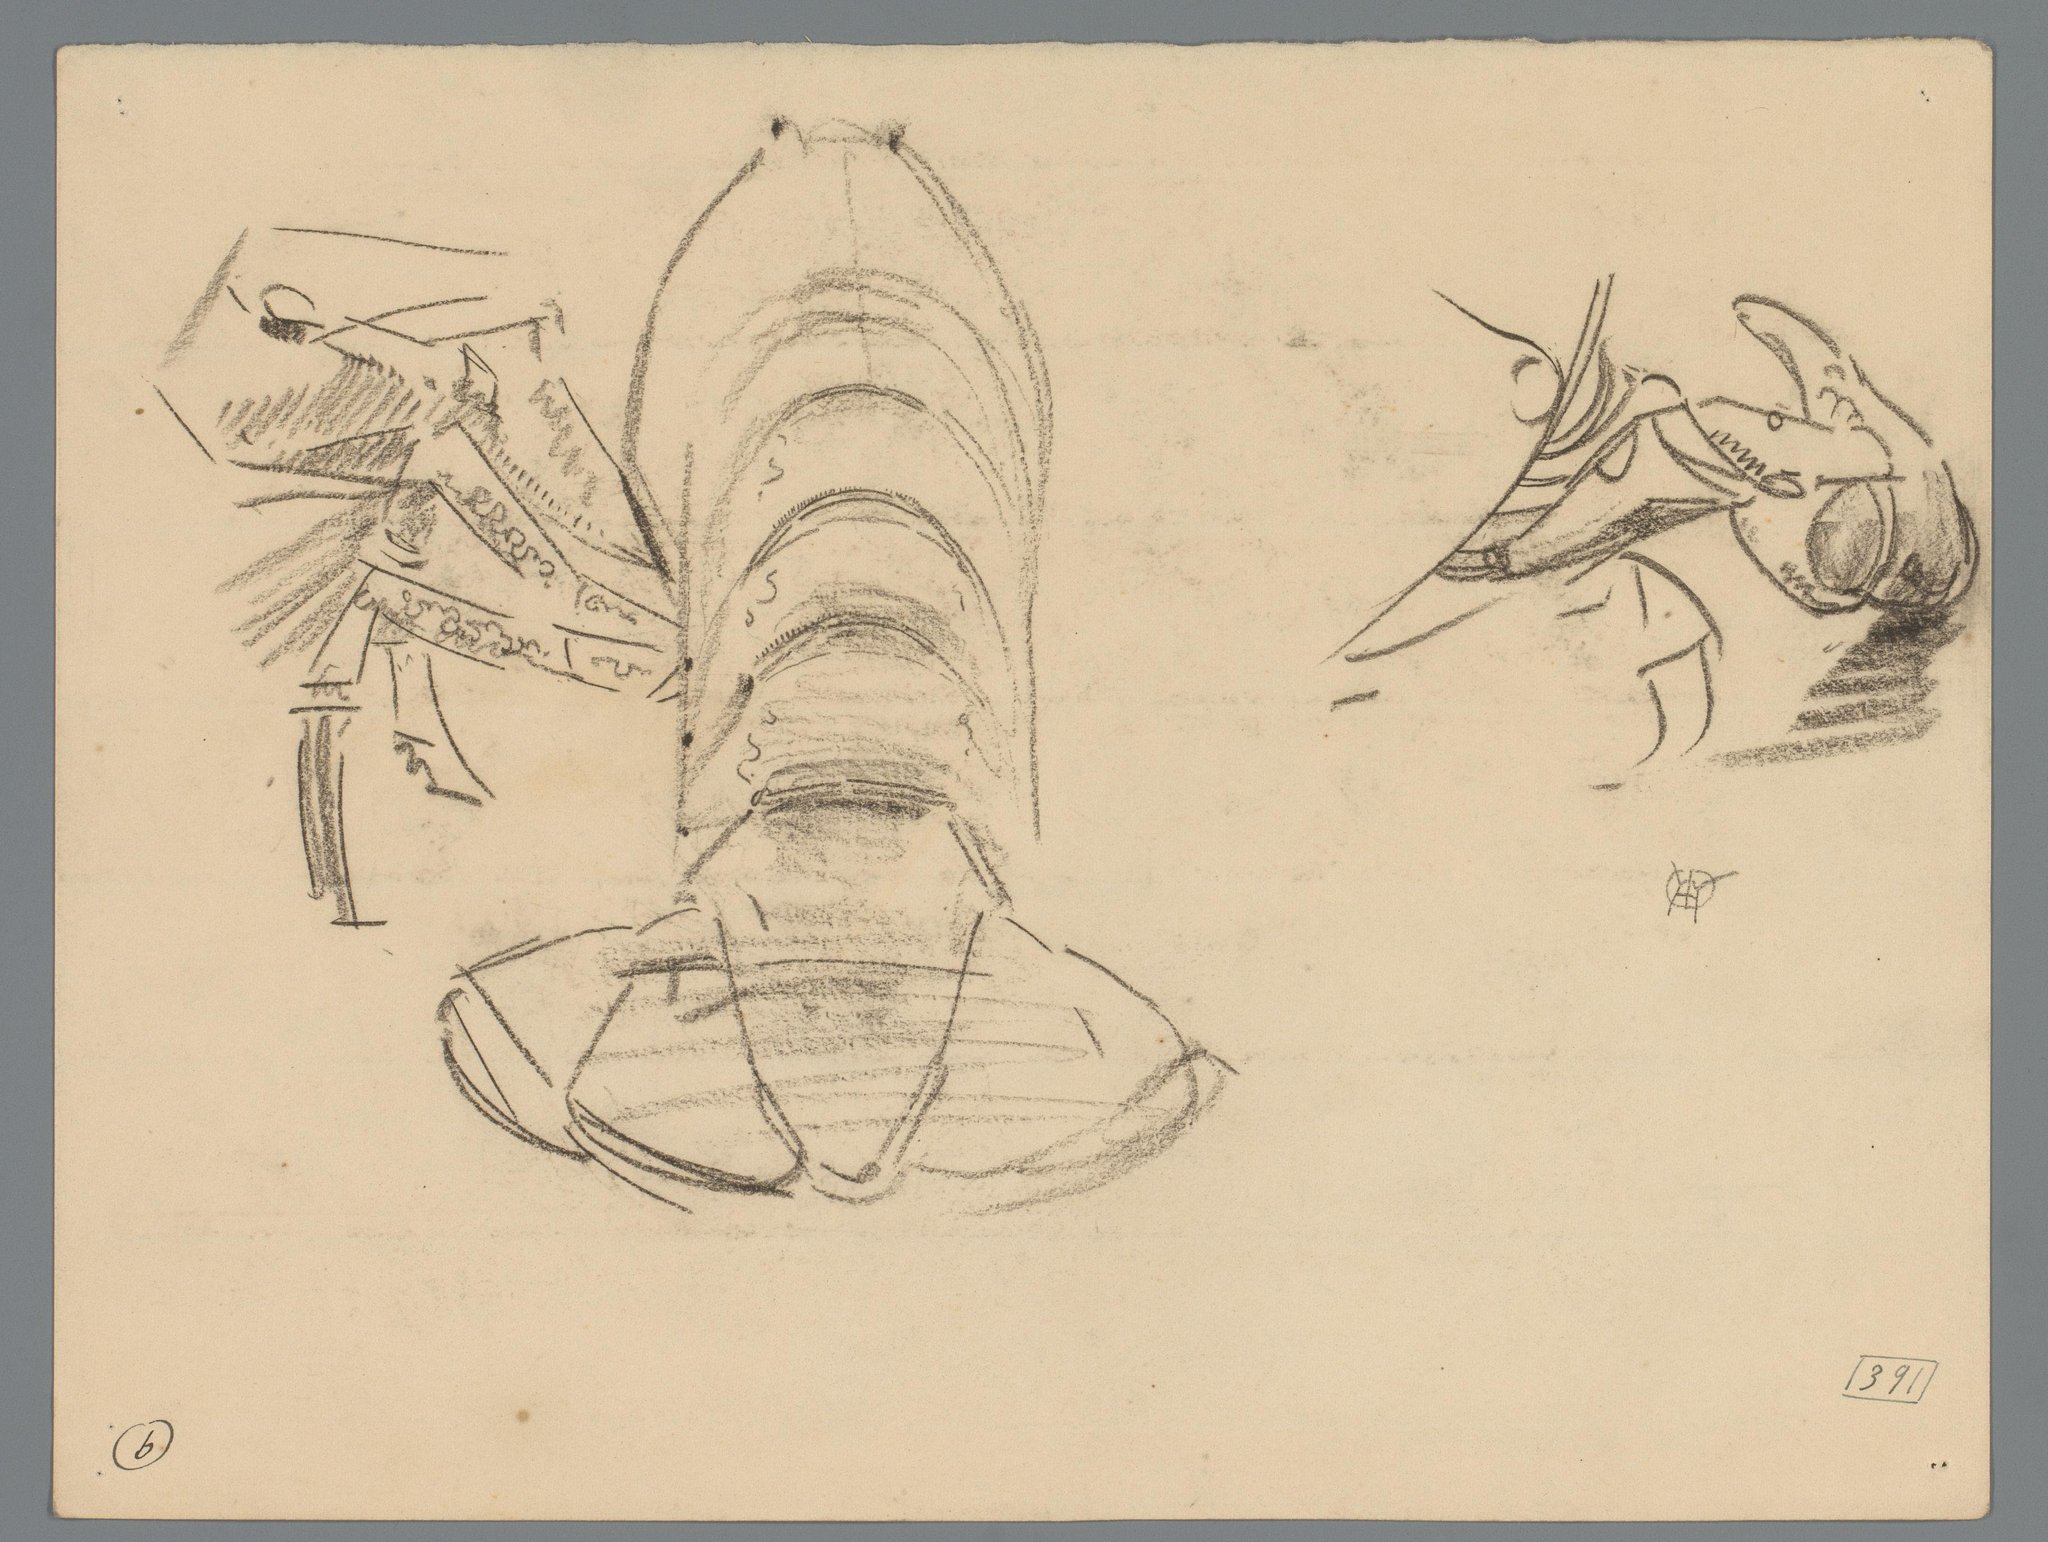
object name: drawing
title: Studie van een kreeft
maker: gerrit willem dijsselhof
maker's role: designer, draughtsman, print maker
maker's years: 1866-1924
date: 1876-1924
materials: chalk, paper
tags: crustaceans: lobster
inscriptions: number: ‘6’, number: ‘391’